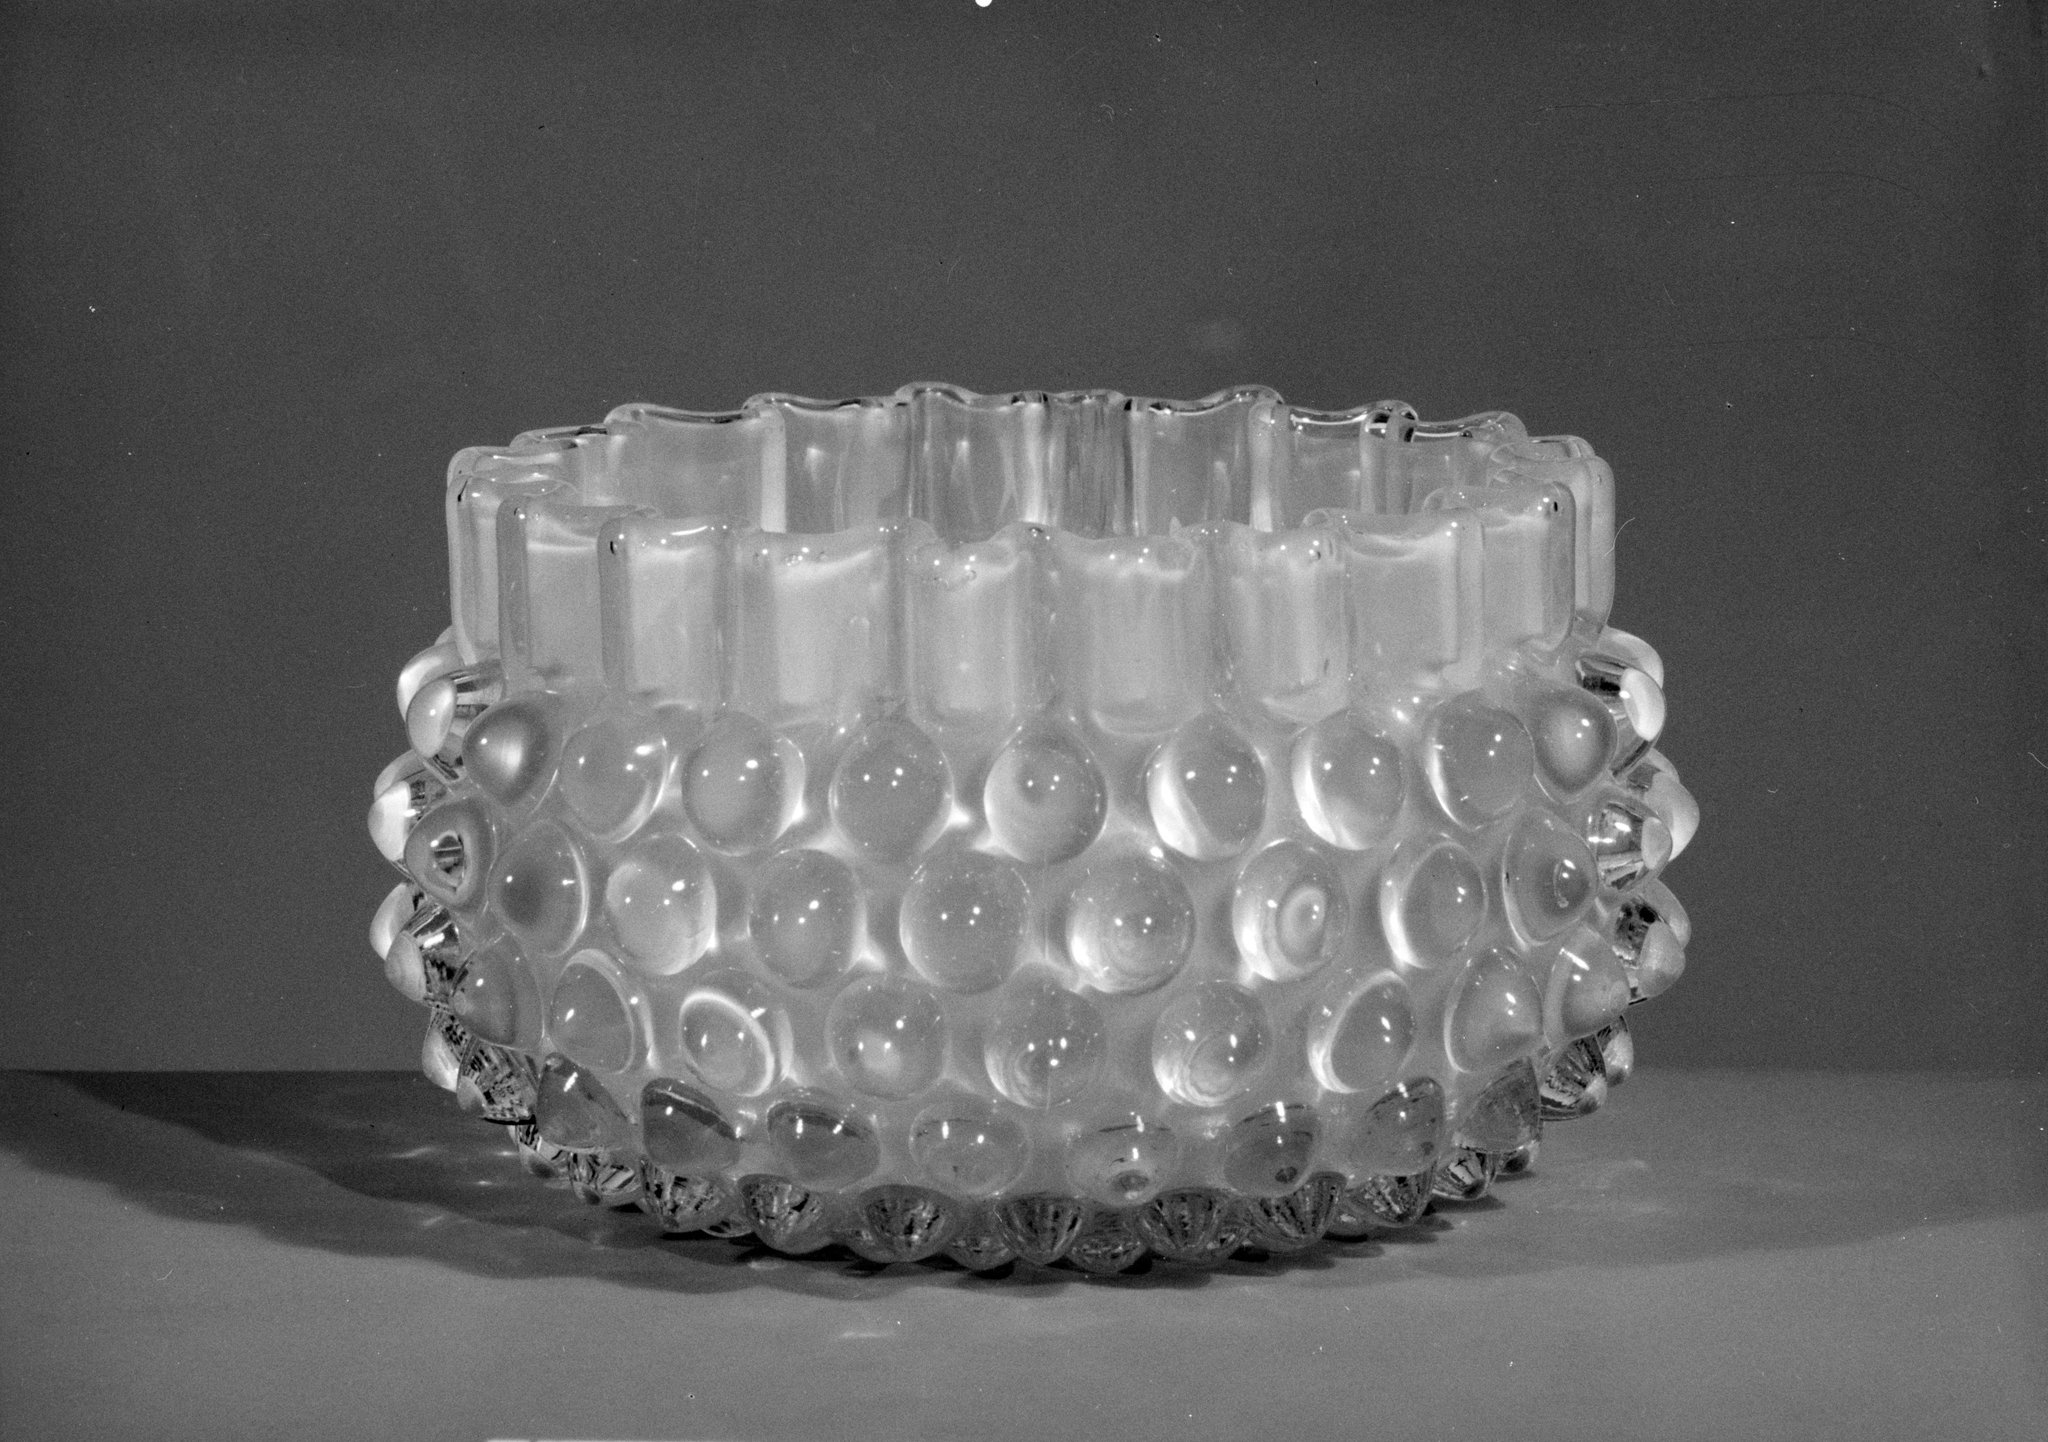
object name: bowl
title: Hobnail bowl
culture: american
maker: hobbs, brockunier and company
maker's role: maker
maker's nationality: american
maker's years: 1863-1891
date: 1886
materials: glass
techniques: pressed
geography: united states